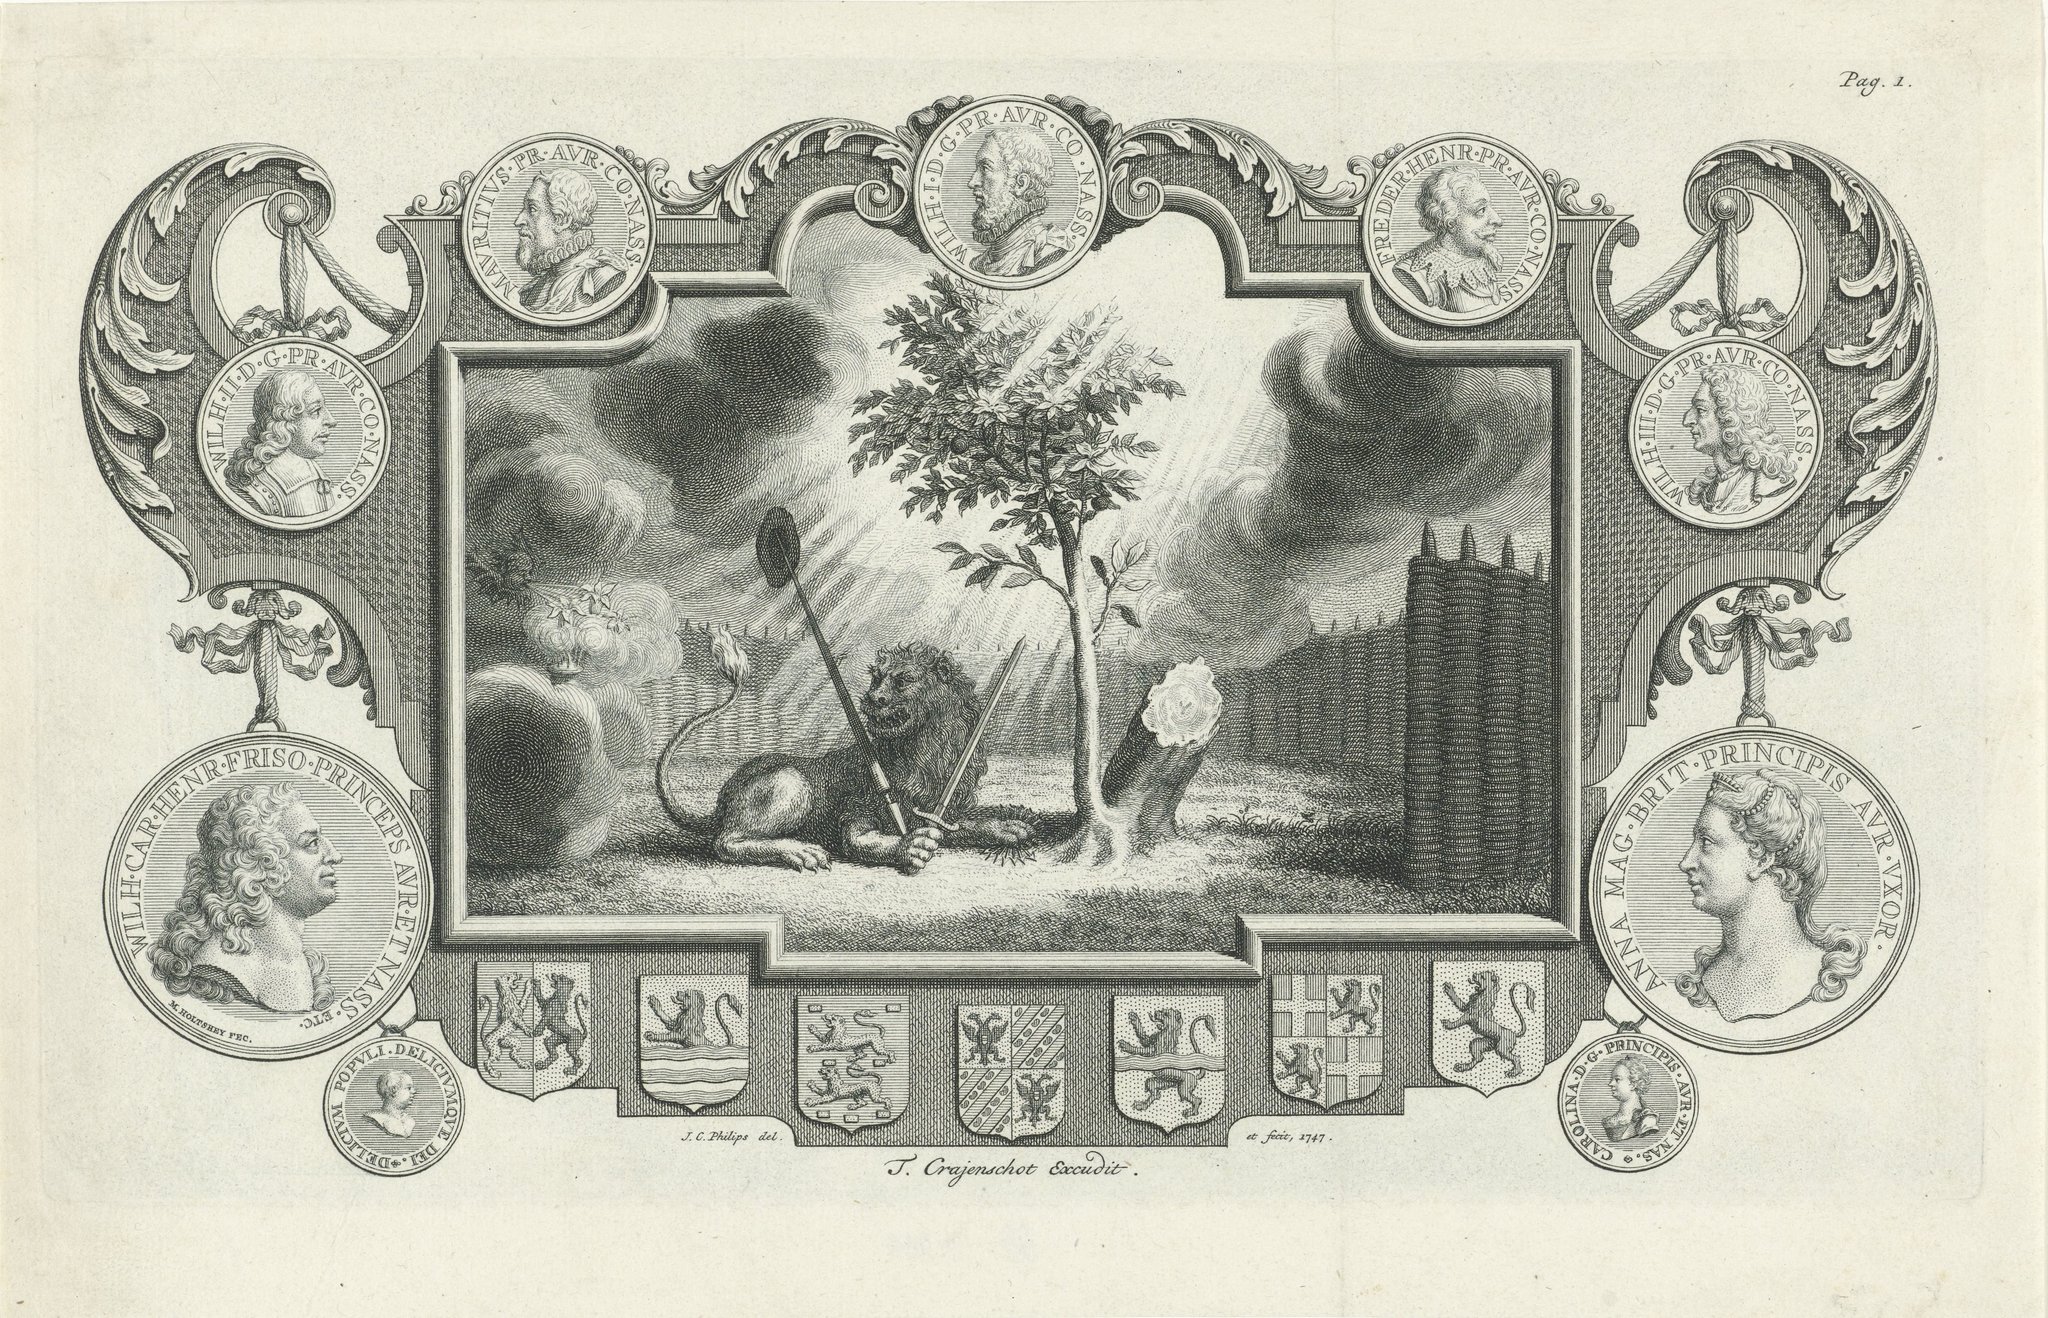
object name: book illustration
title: Allegorie op de verheffing van Willem IV tot stadhouder in 1747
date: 1747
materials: paper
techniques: engraving, etching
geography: amsterdam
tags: the hague, willem iv (prins van oranje-nassau), anna van hannover, fenced or walled garden; 'hortus conclusus'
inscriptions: collector's mark: Lugt 2228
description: Allegorie op de verheffing van prins Willem IV tot stadhouder in mei 1747. De Nederlandse Leeuw met zwaard, lans en vrijheidshoed wakend in de Hollandse Tuin bij de door het goddelijke licht beschenen Oranjeboom. In omlijsting met wapens van de zeven provincies en portretmedaillons van prins Willem IV en zijn vrouw Anna van Hannover en de eerdere prinsen van Oranje. Rechtsboven: Pag. 1.